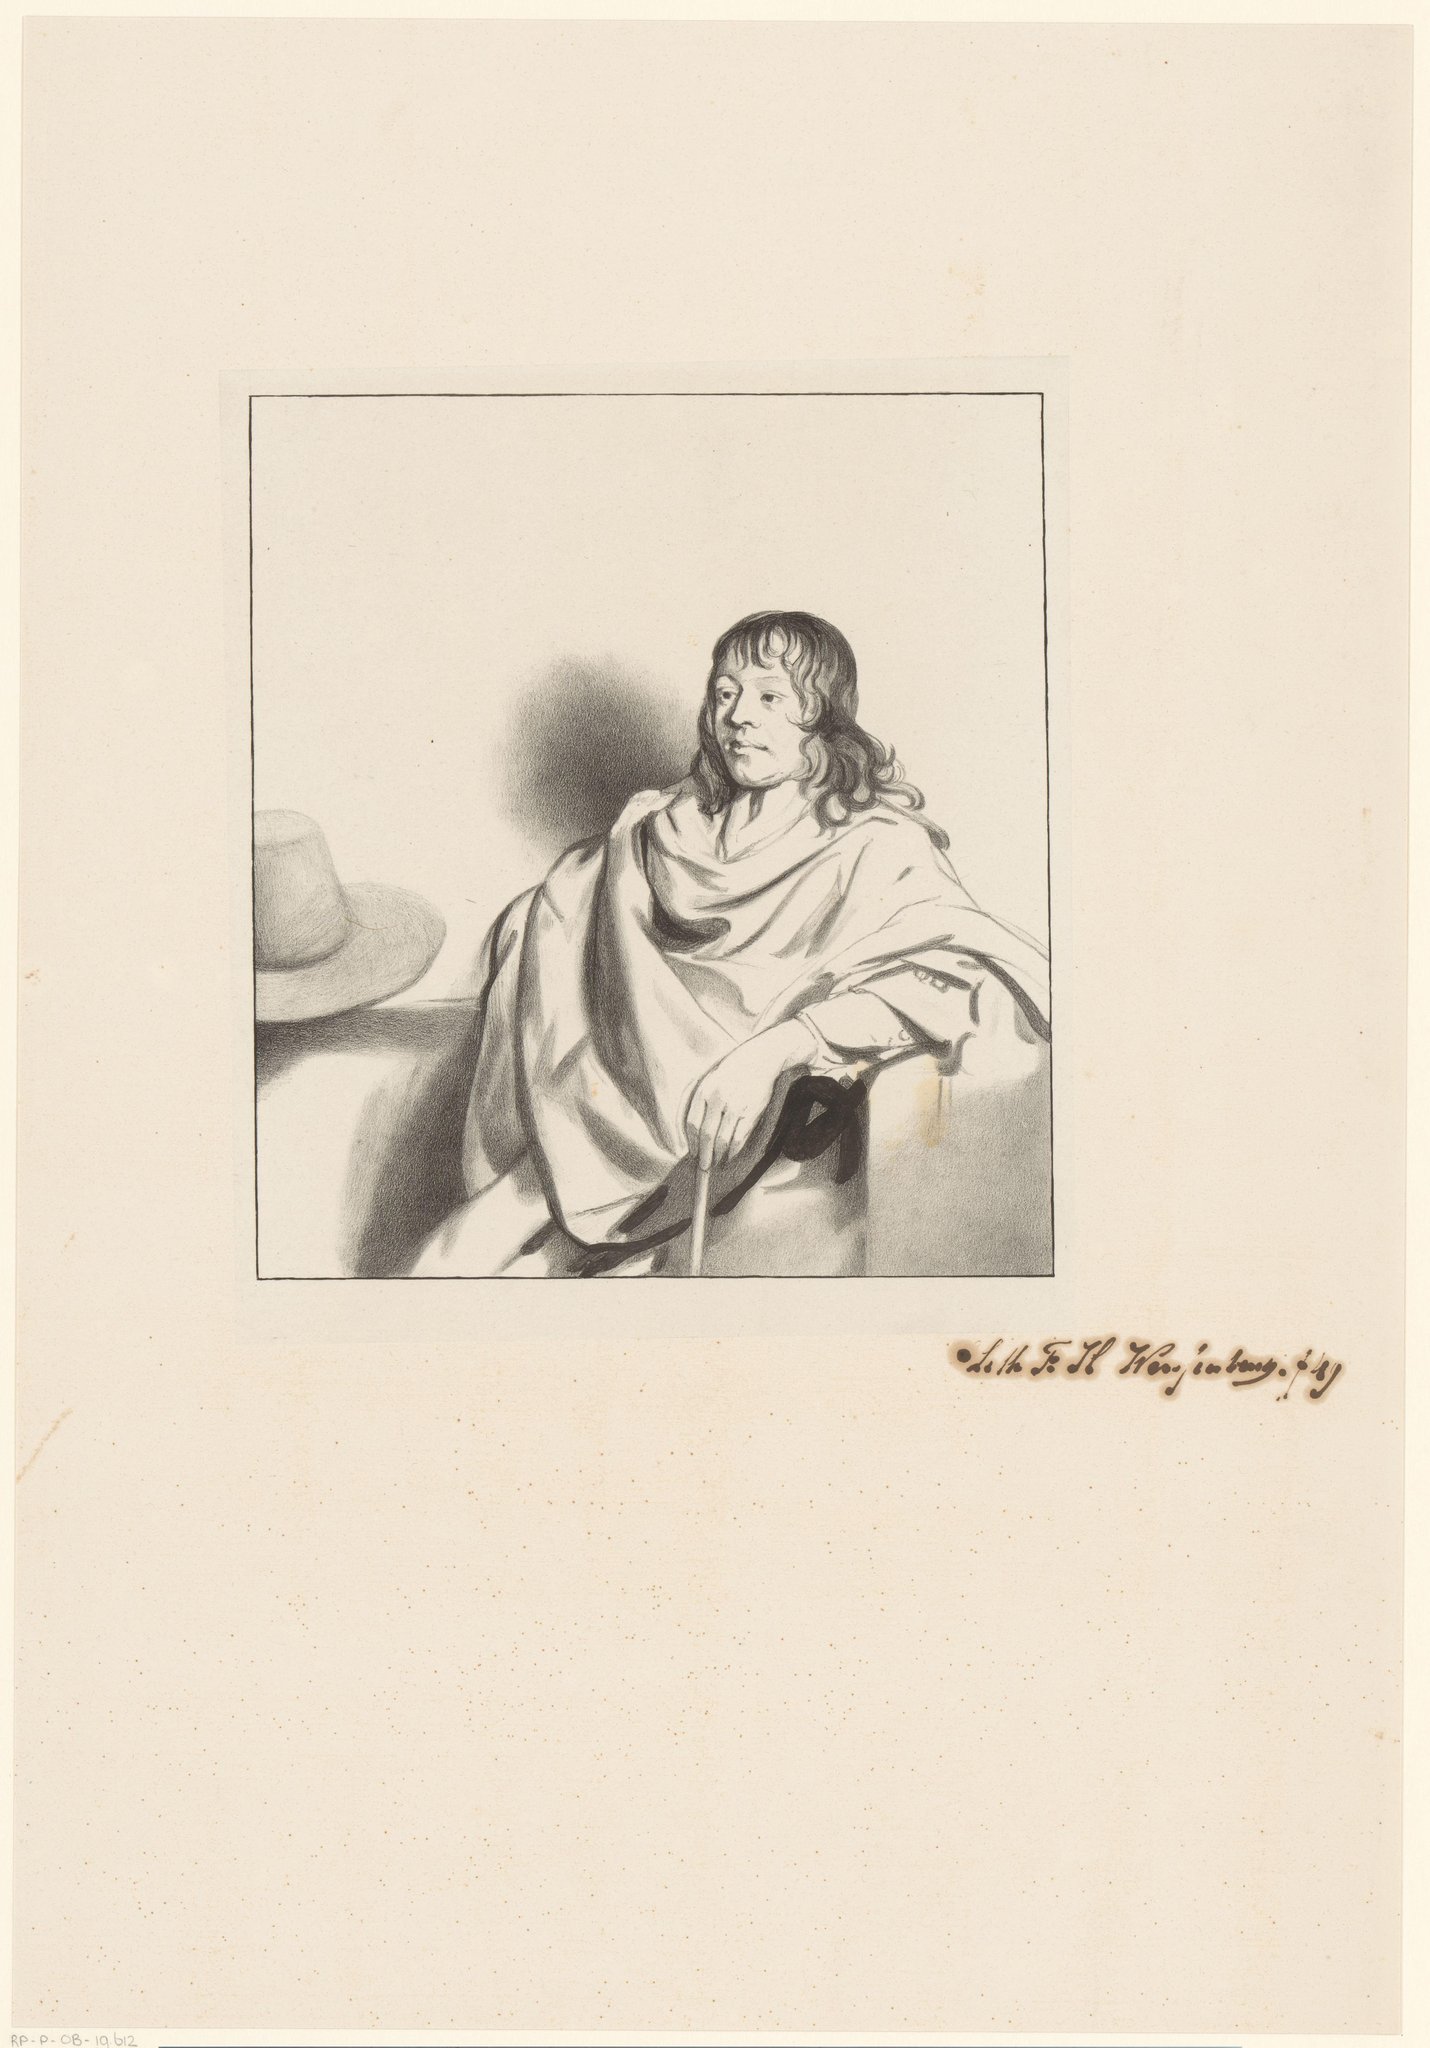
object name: print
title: Portret van onbekende man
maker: frederik hendrik weissenbruch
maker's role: draughtsman, print maker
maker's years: 1828-1887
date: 1849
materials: paper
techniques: lithograph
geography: netherlands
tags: anonymous historical person portrayed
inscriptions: collector's mark: Lugt 2228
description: Man zittend naar links, op een tafel ligt zijn hoed. In zijn hand houdt hij een stok.